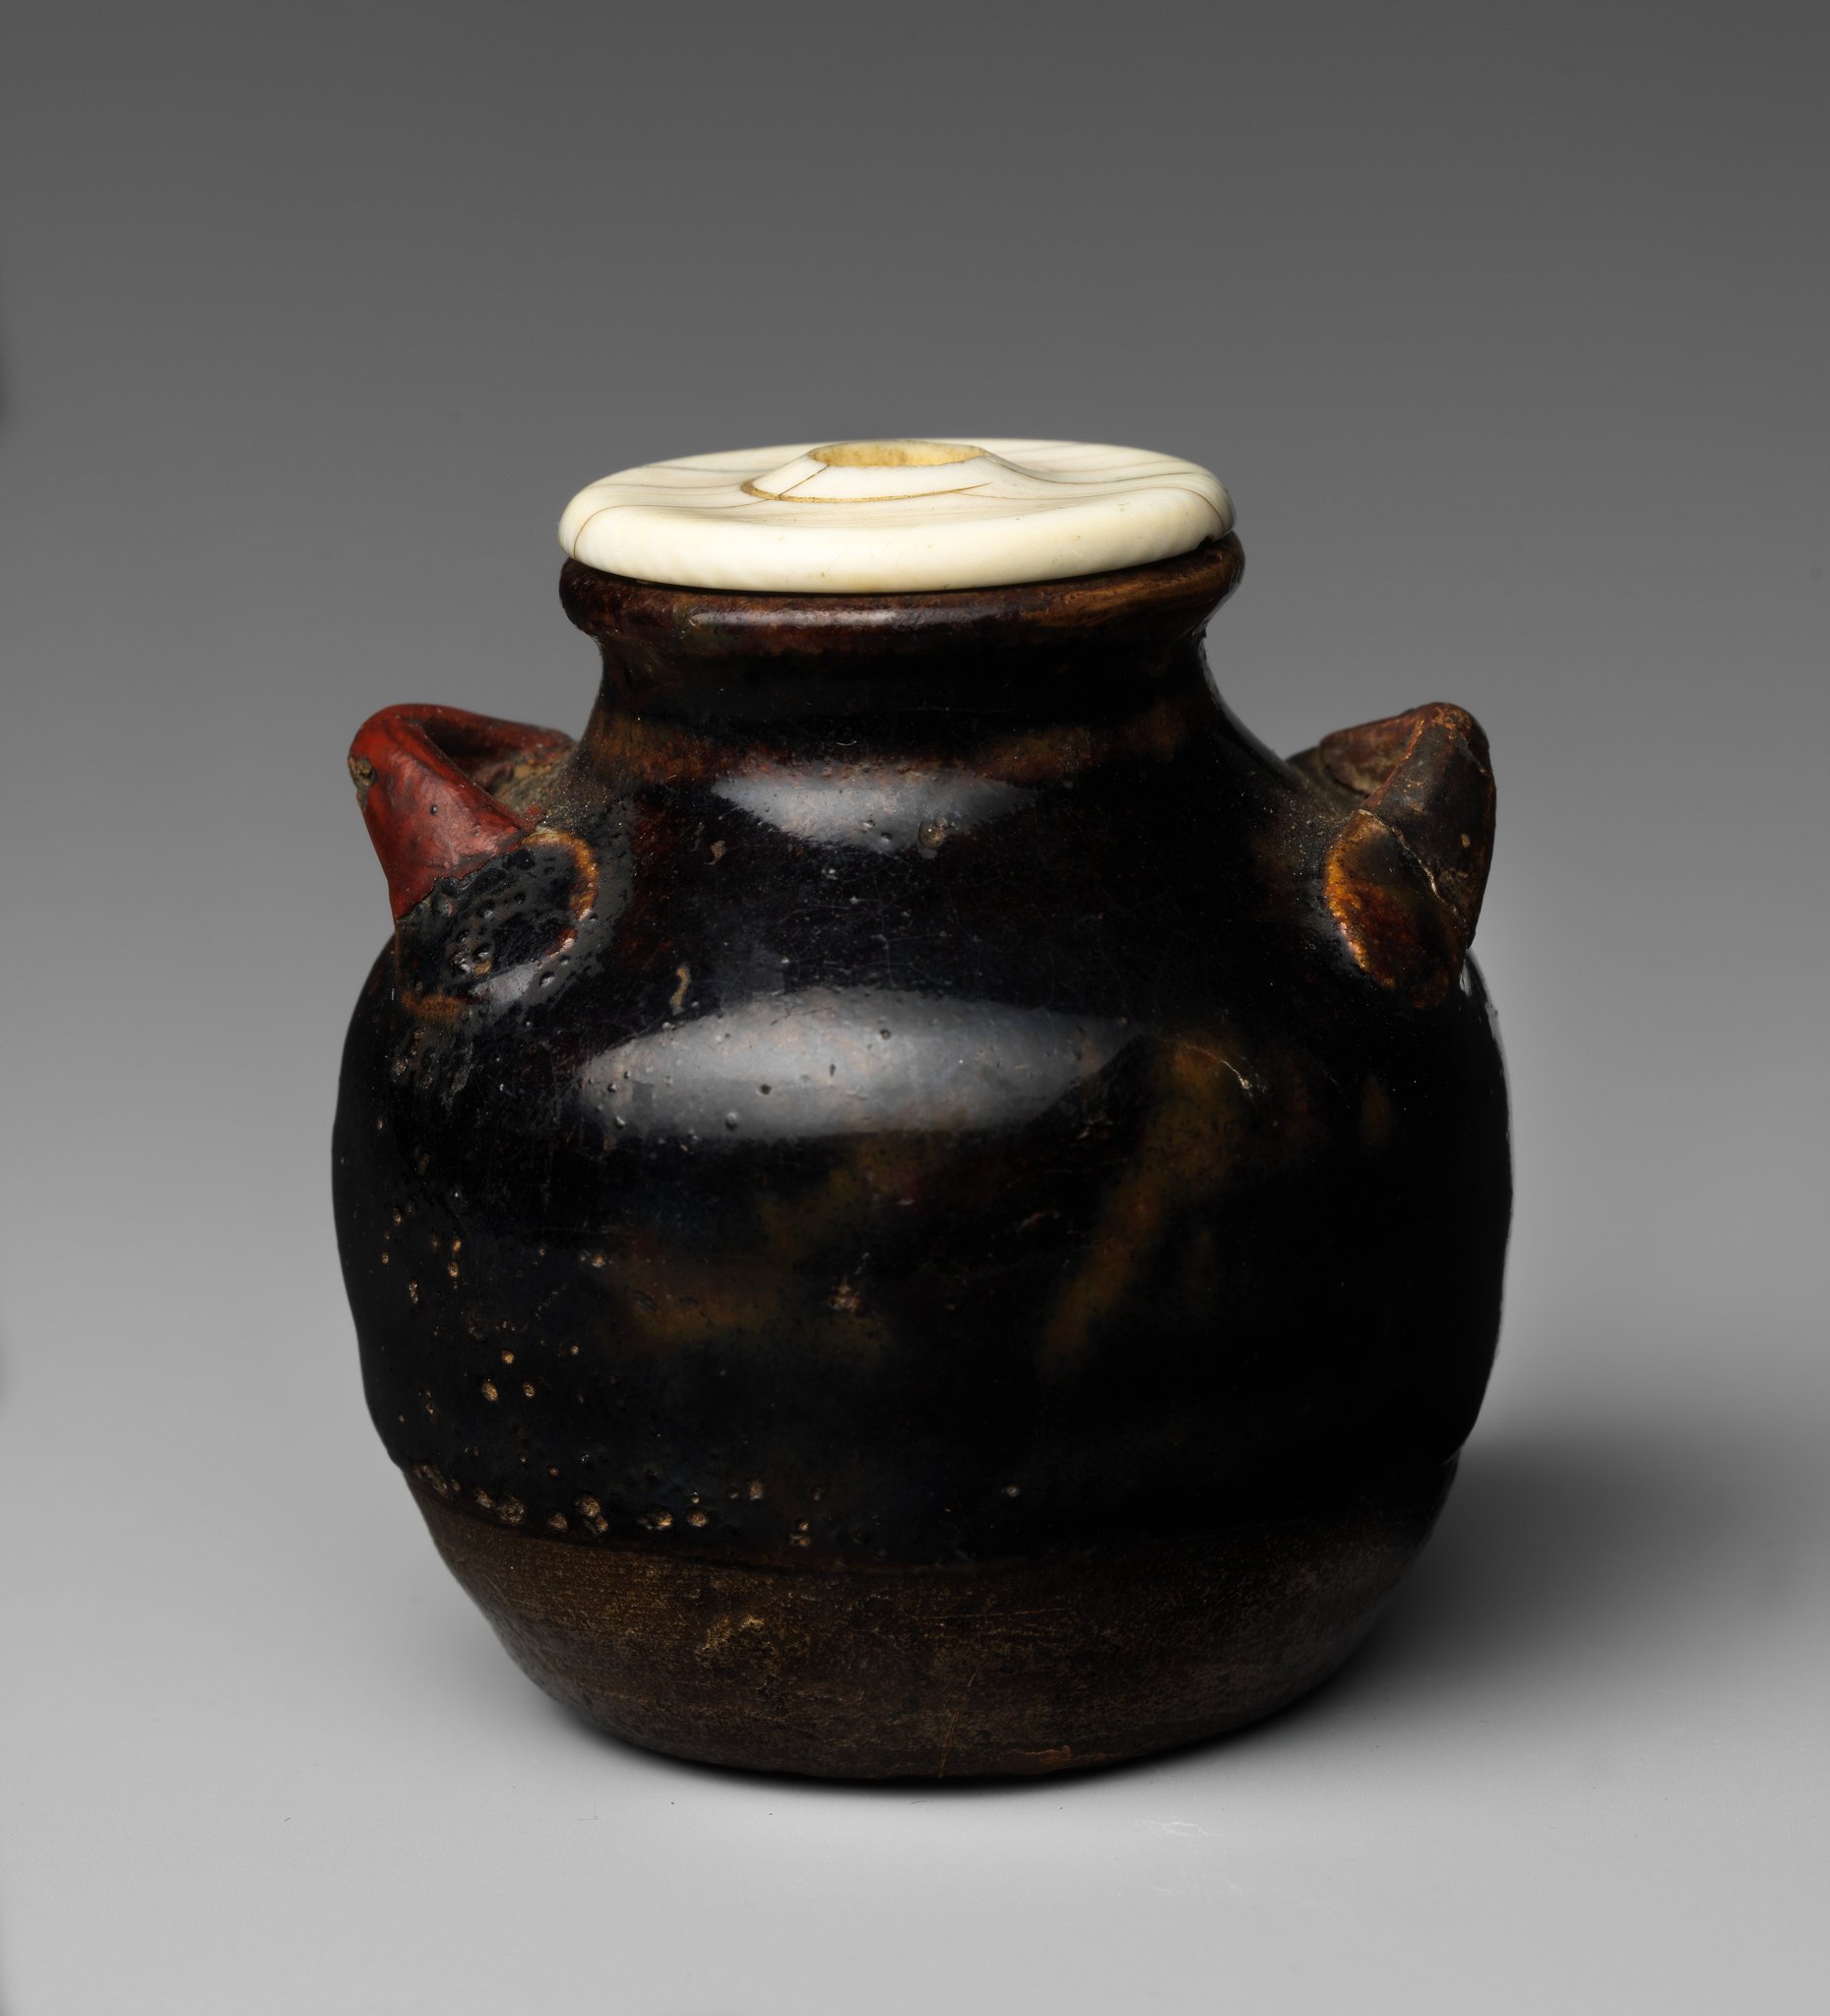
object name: jar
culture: japanese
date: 1601-1700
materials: clay, glaze